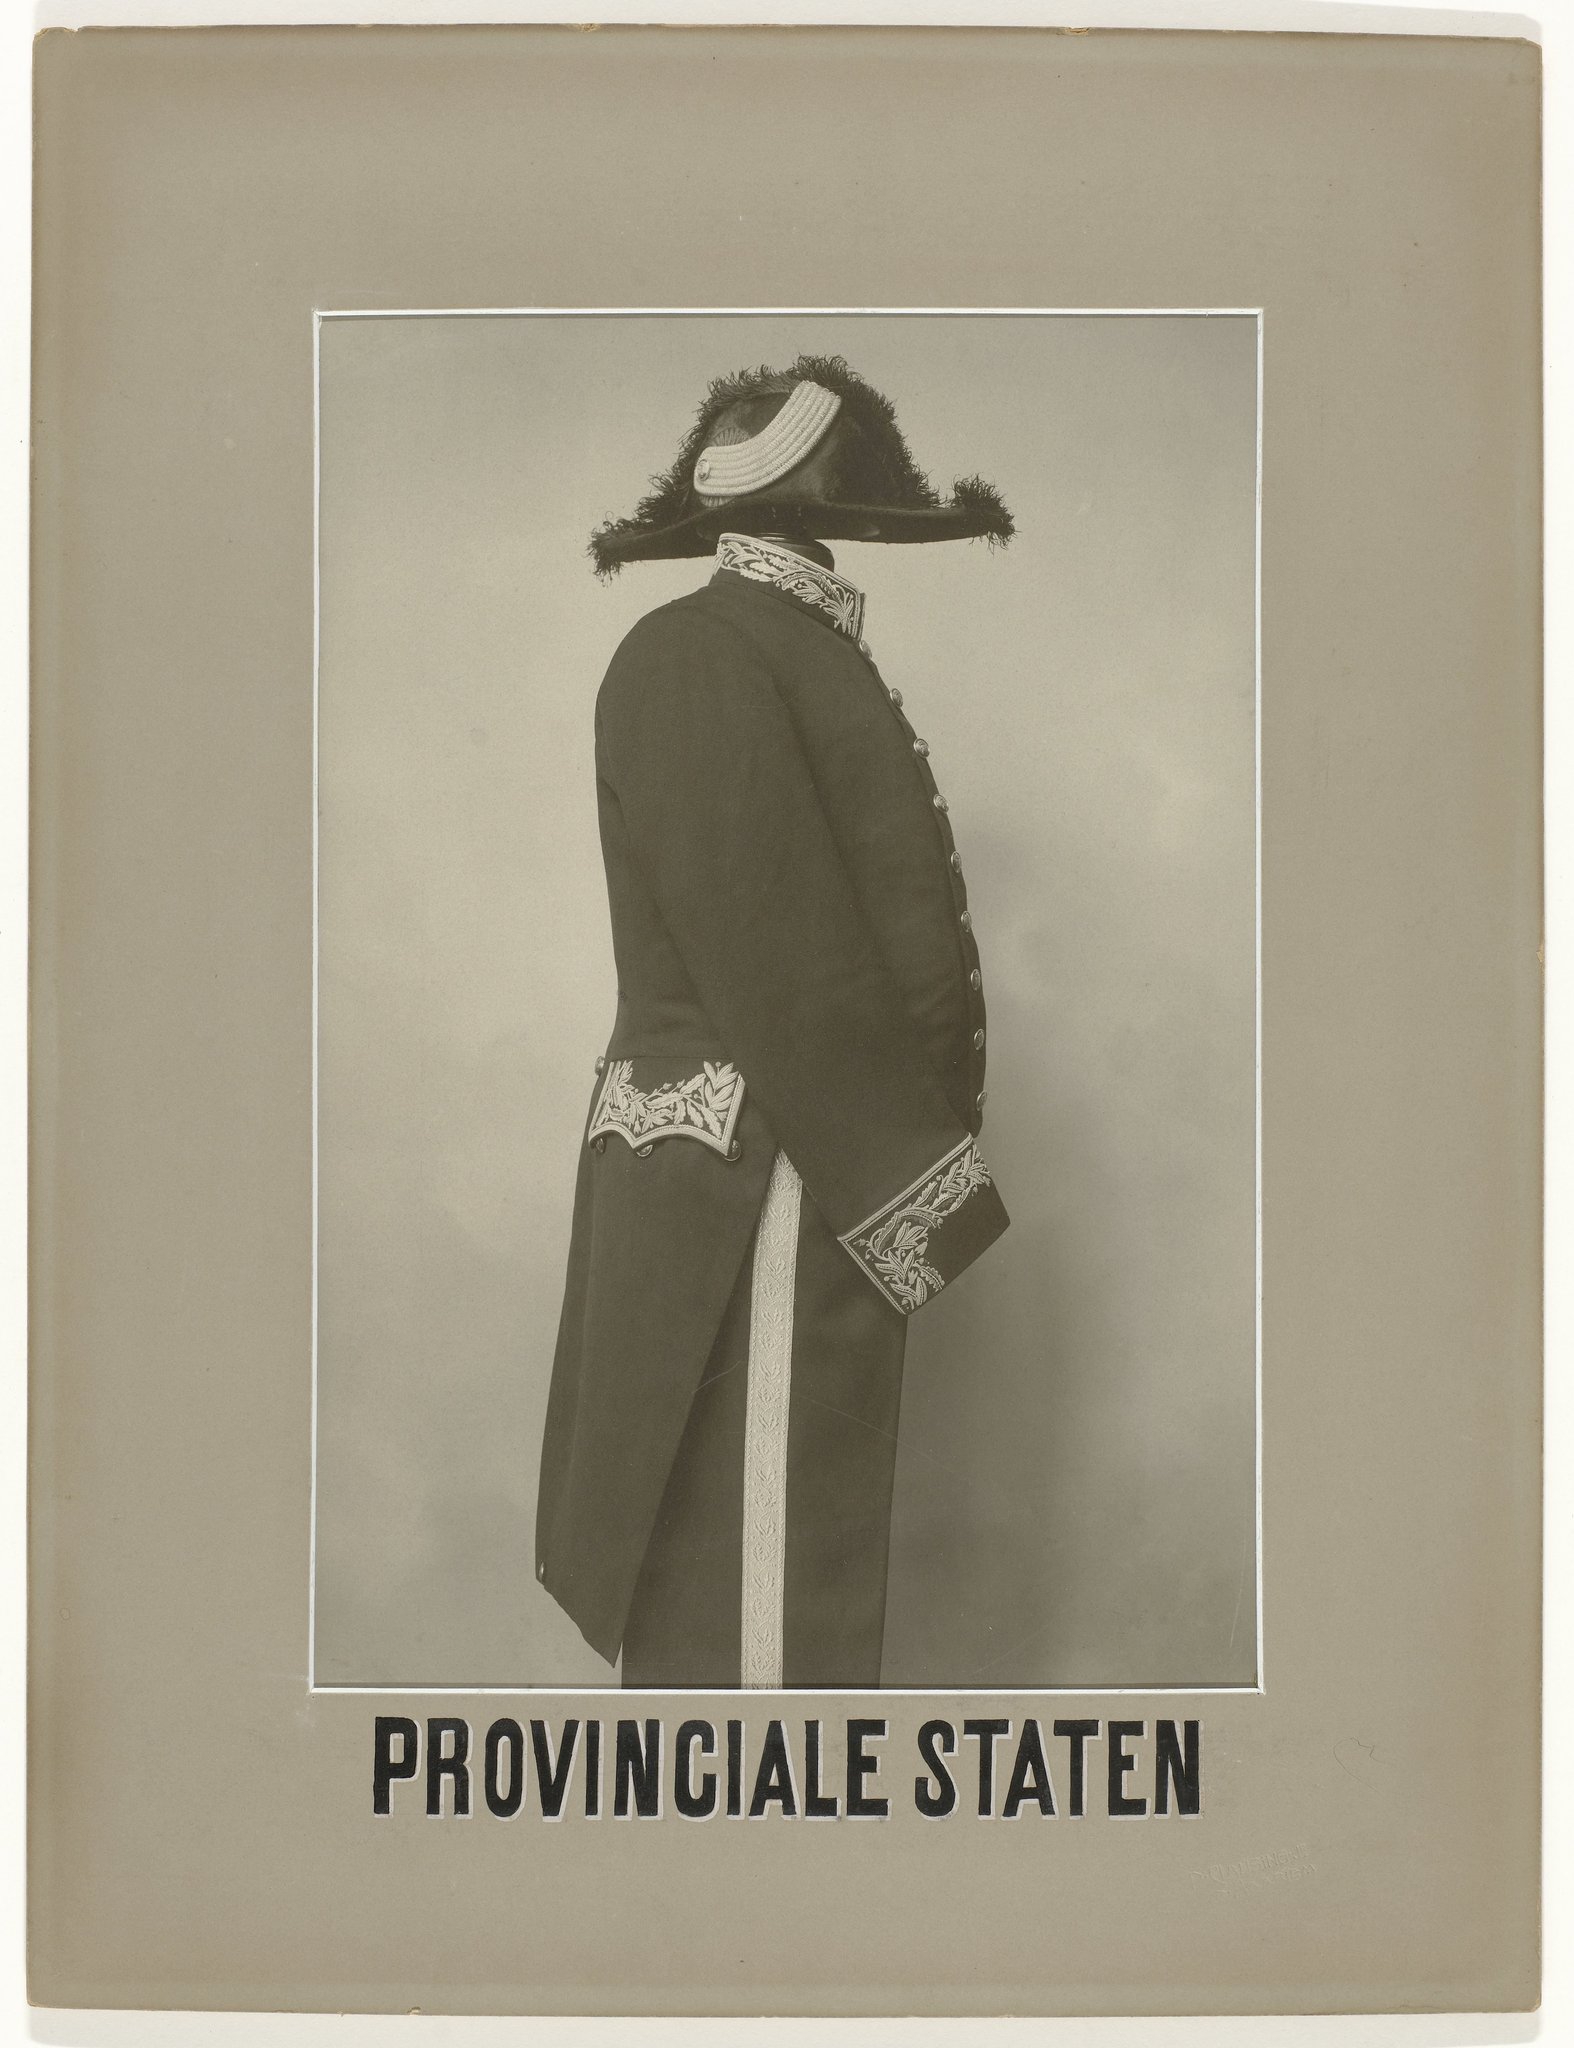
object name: photograph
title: Provinciale Staten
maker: peter clausing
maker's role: fotograaf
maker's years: 1870-1913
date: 1875-1900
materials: cardboard, paper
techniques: photography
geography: haarlem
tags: netherlands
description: Eén van acht foto's van ambtskostuums, in grijsbruin passe-partout met onder benaming in verf, kapitalen, zwarte letter met witte 'schaduw'. Onderschrift: PROVINCIALE STATEN. Gemerkt; r.o.: reliëfstempel: 'P. Clausing jr / Haarlem'. Opmerking: zie NG-1029-A t/m H.